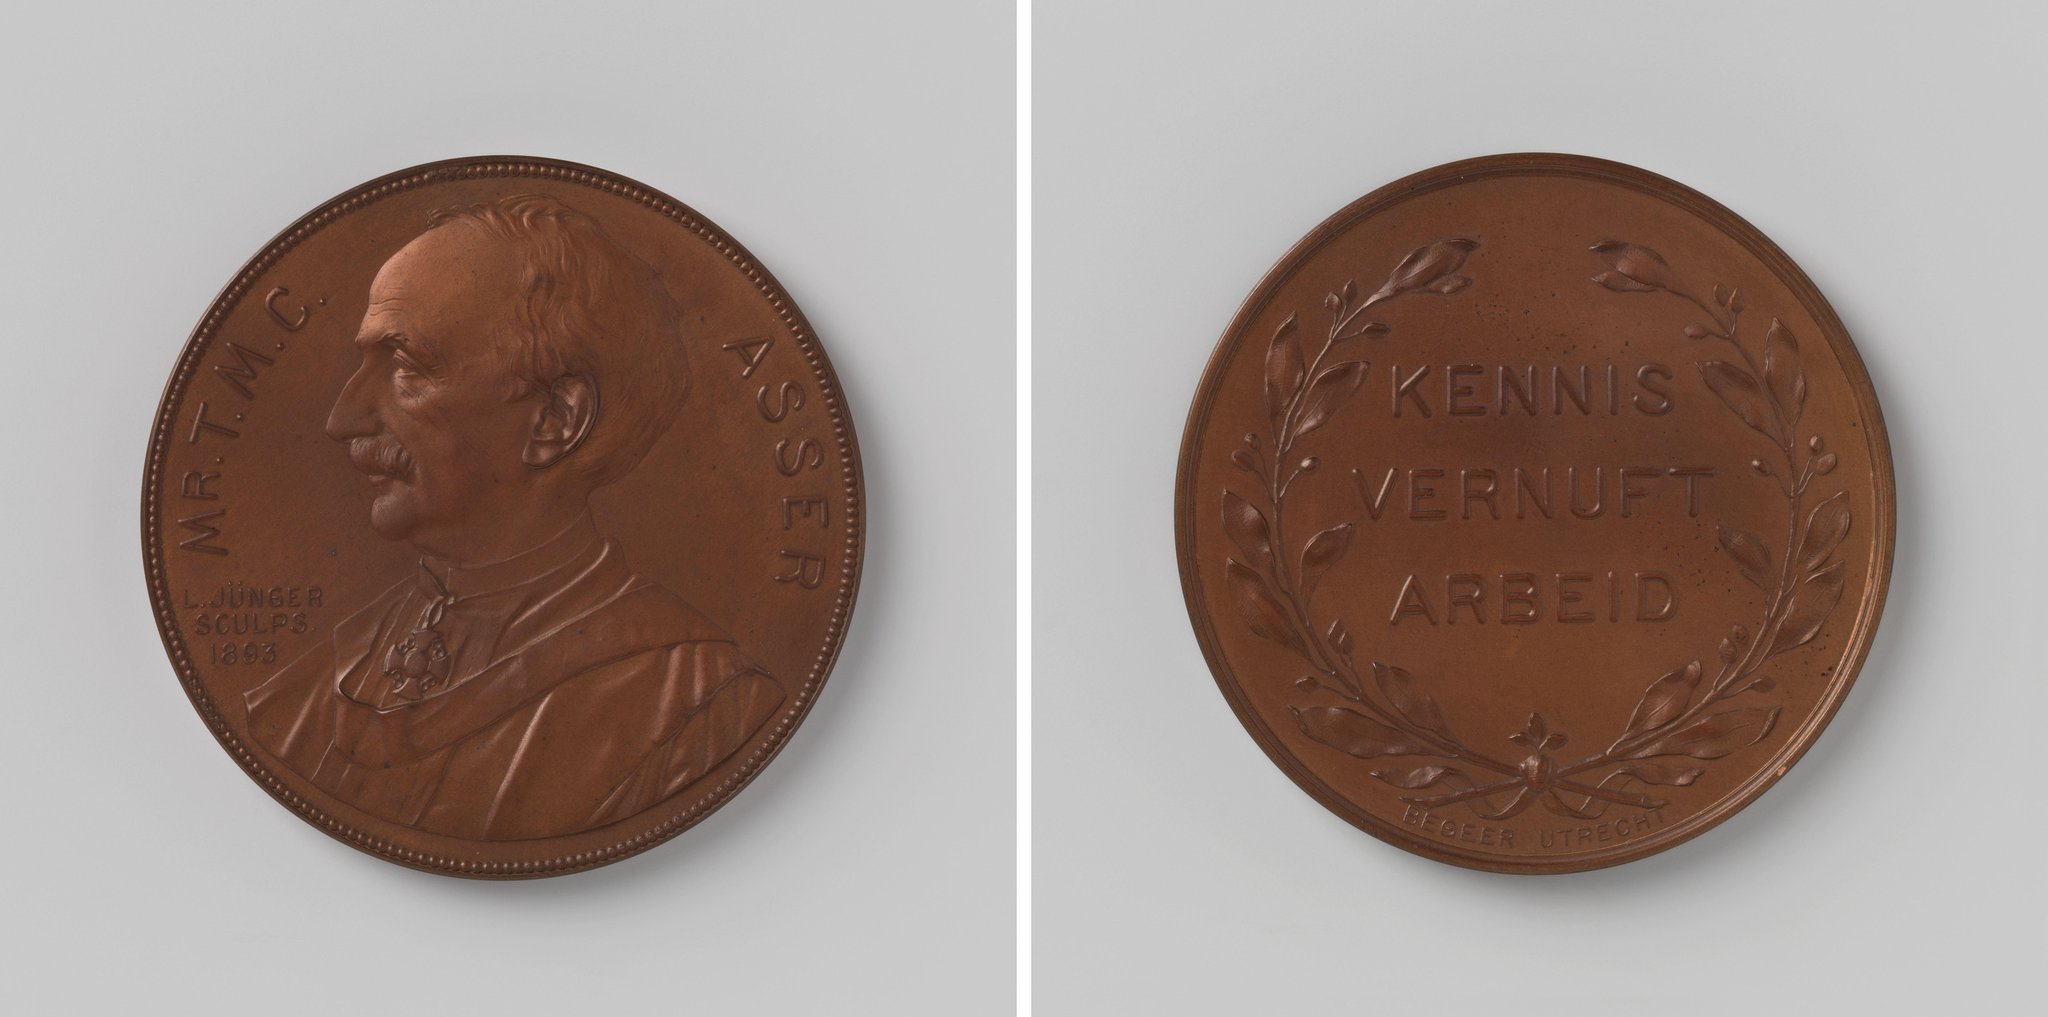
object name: honorary medal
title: Historiepenning op Mr. T.M.C. Asser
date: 1893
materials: bronze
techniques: striking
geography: utrecht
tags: amsterdam, the hague, utrecht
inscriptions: date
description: Bronzen penning. Voorzijde: Borstbeeld van een man in toga in profiel naar links, met een ordeteken om de hals. (Mr. T. M. C. Asser, hoogleraar in de rechten). Opschrift rand: MR. T.M.C. ASSER L. JÜNGER SCULPS. 1893. Keerzijde: Opschrift binnen lauwerkrans: KENNIS VERNUFT ARBEID / BEGEER UTRECHT.